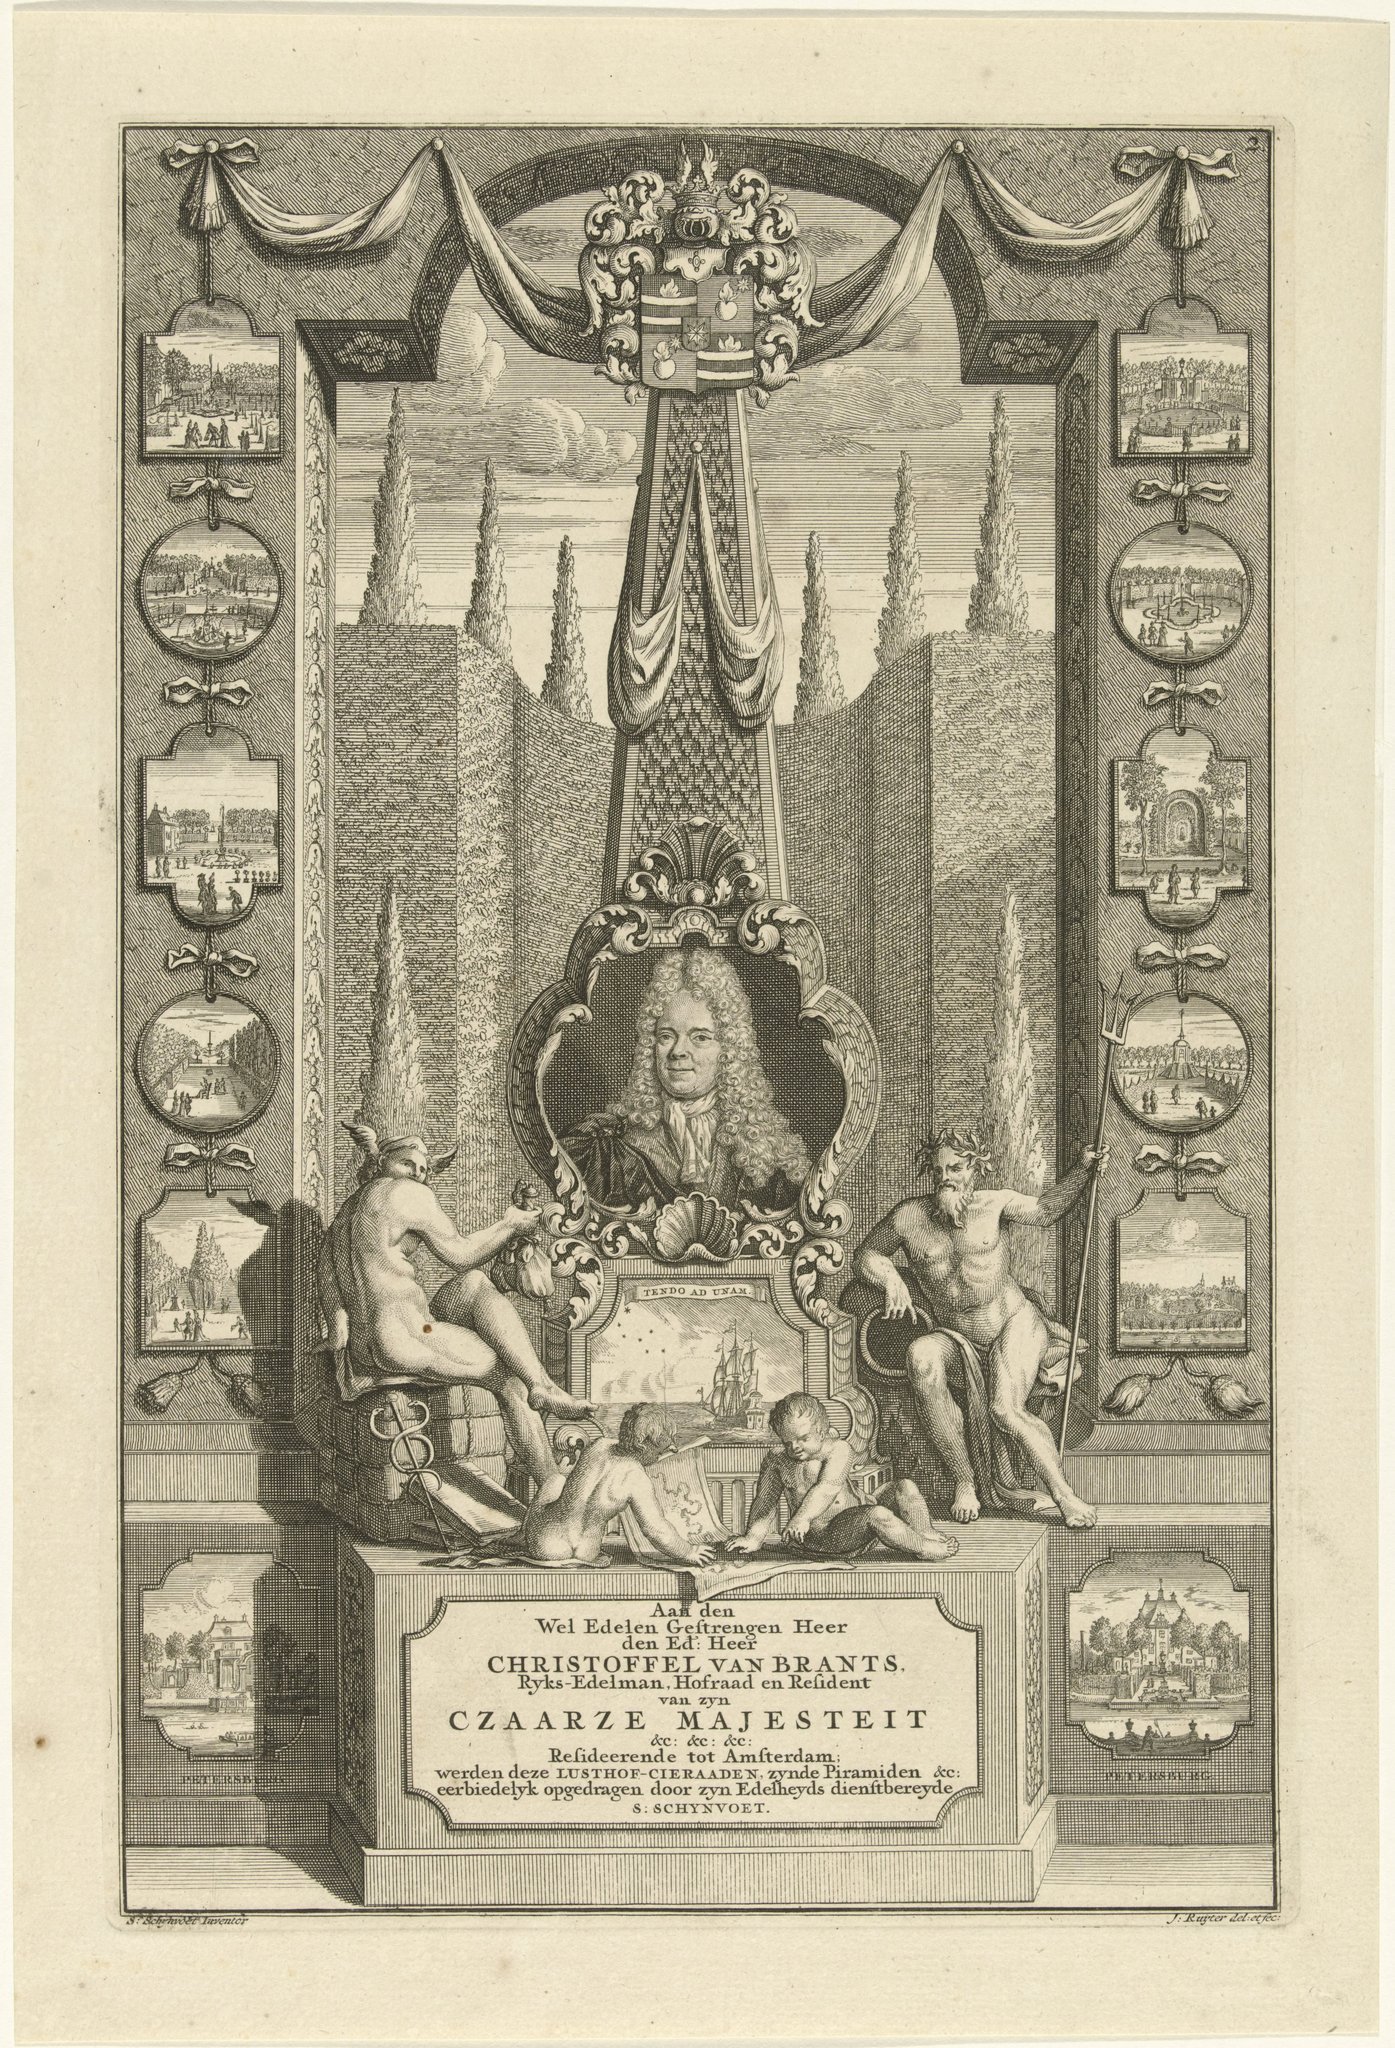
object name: print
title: Portret van Christoffel van Brants met opdracht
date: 1722-1727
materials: paper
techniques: engraving, etching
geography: amsterdam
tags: amsterdam, christoffel van brants, (story of) neptune (poseidon), sailing-ship, sailing-boat, (story of) mercury (hermes), maps, atlases, historical persons, french or architectonic garden; formal garden, villa, armorial bearing, heraldry, country-house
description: Allegorisch portret van de lutherse koopman Christoffel van Brants, die in 1717 door tsaar Peter de Grote tot de Russische adelstand werd verheven en werd benoemd tot Russisch ambassadeur te Amsterdam. Zijn portret staat tegen een obelisk in een tuin, geflankeerd door Mercurius en Neptunus. Bovenin de obelisk zijn wapen. Onder het portret een zeilschip op zee en twee kinderen met een kaart. Daaronder de aan hem gerichte opdracht van Simon Schijnvoet. Langs de zijkanten gezichten op de door Schijnvoet ontworpen tuin van zijn buitenplaats 'Petersburg' aan de Vecht. Rechtsboven genummerd: 2.